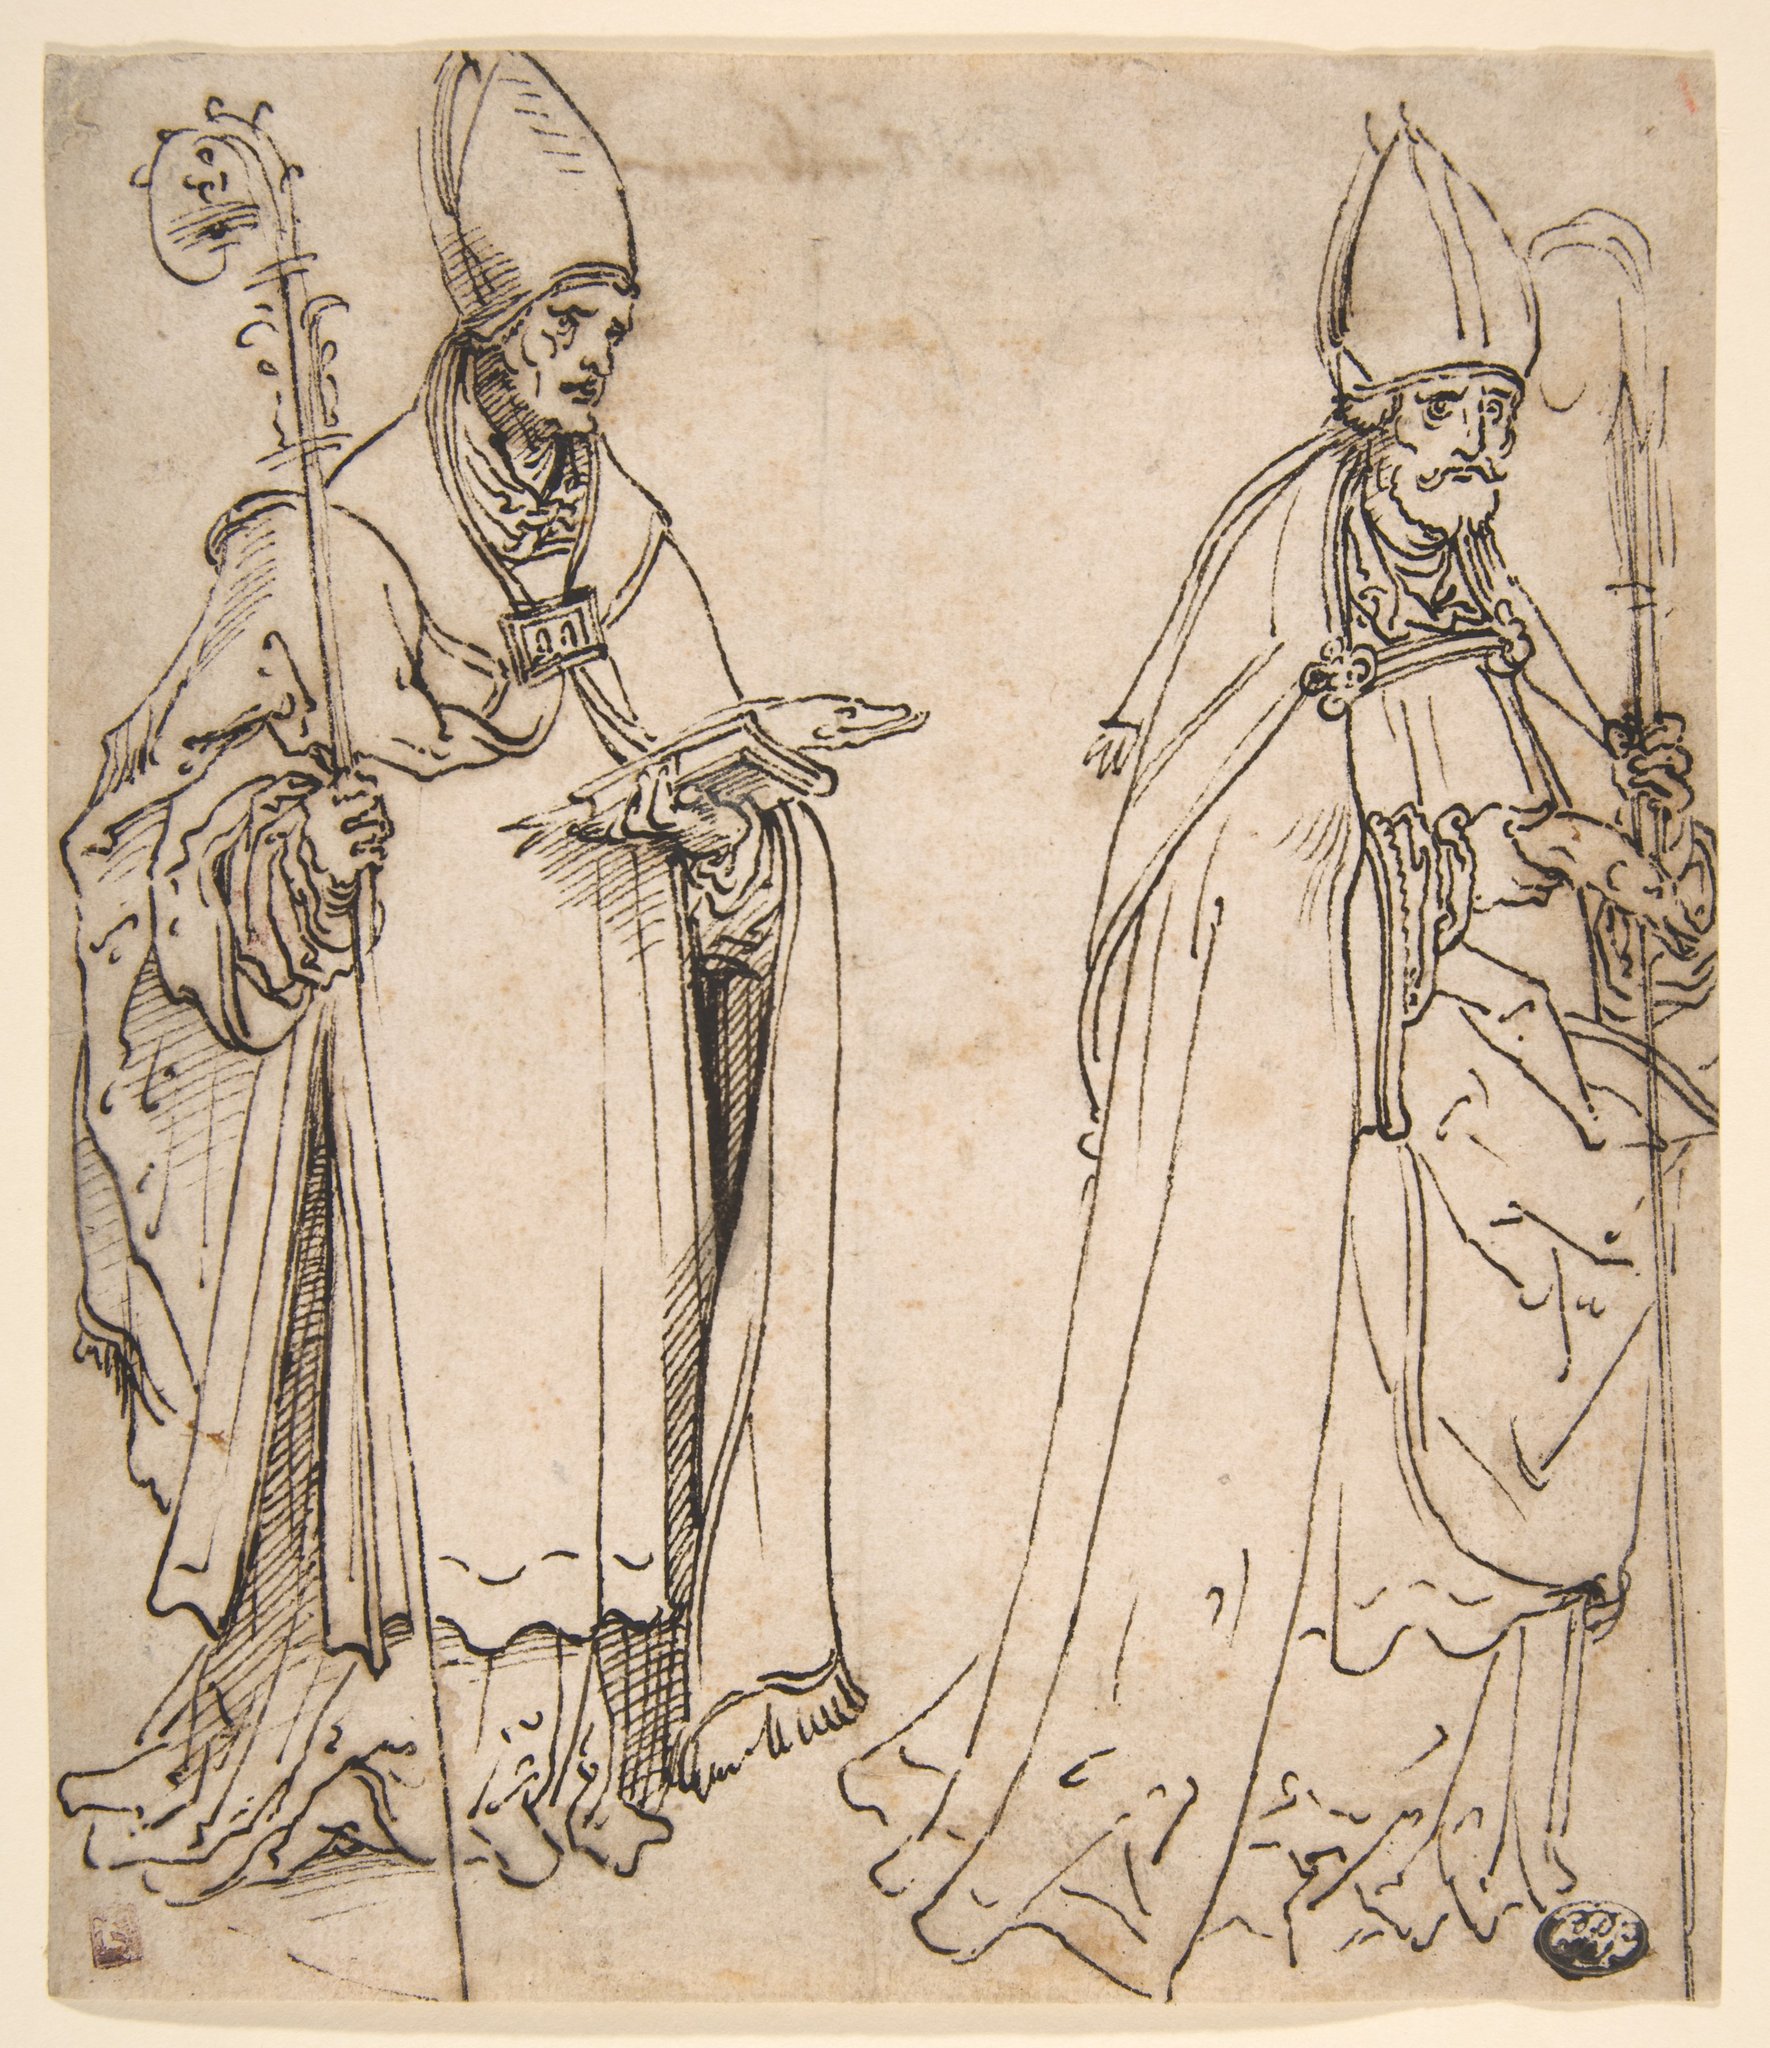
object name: drawing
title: Two studies for Saint Ulrich of Augsburg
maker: hans burgkmair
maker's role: artist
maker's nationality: german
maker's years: 1473-1531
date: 1505-1508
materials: ink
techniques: pen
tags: saints